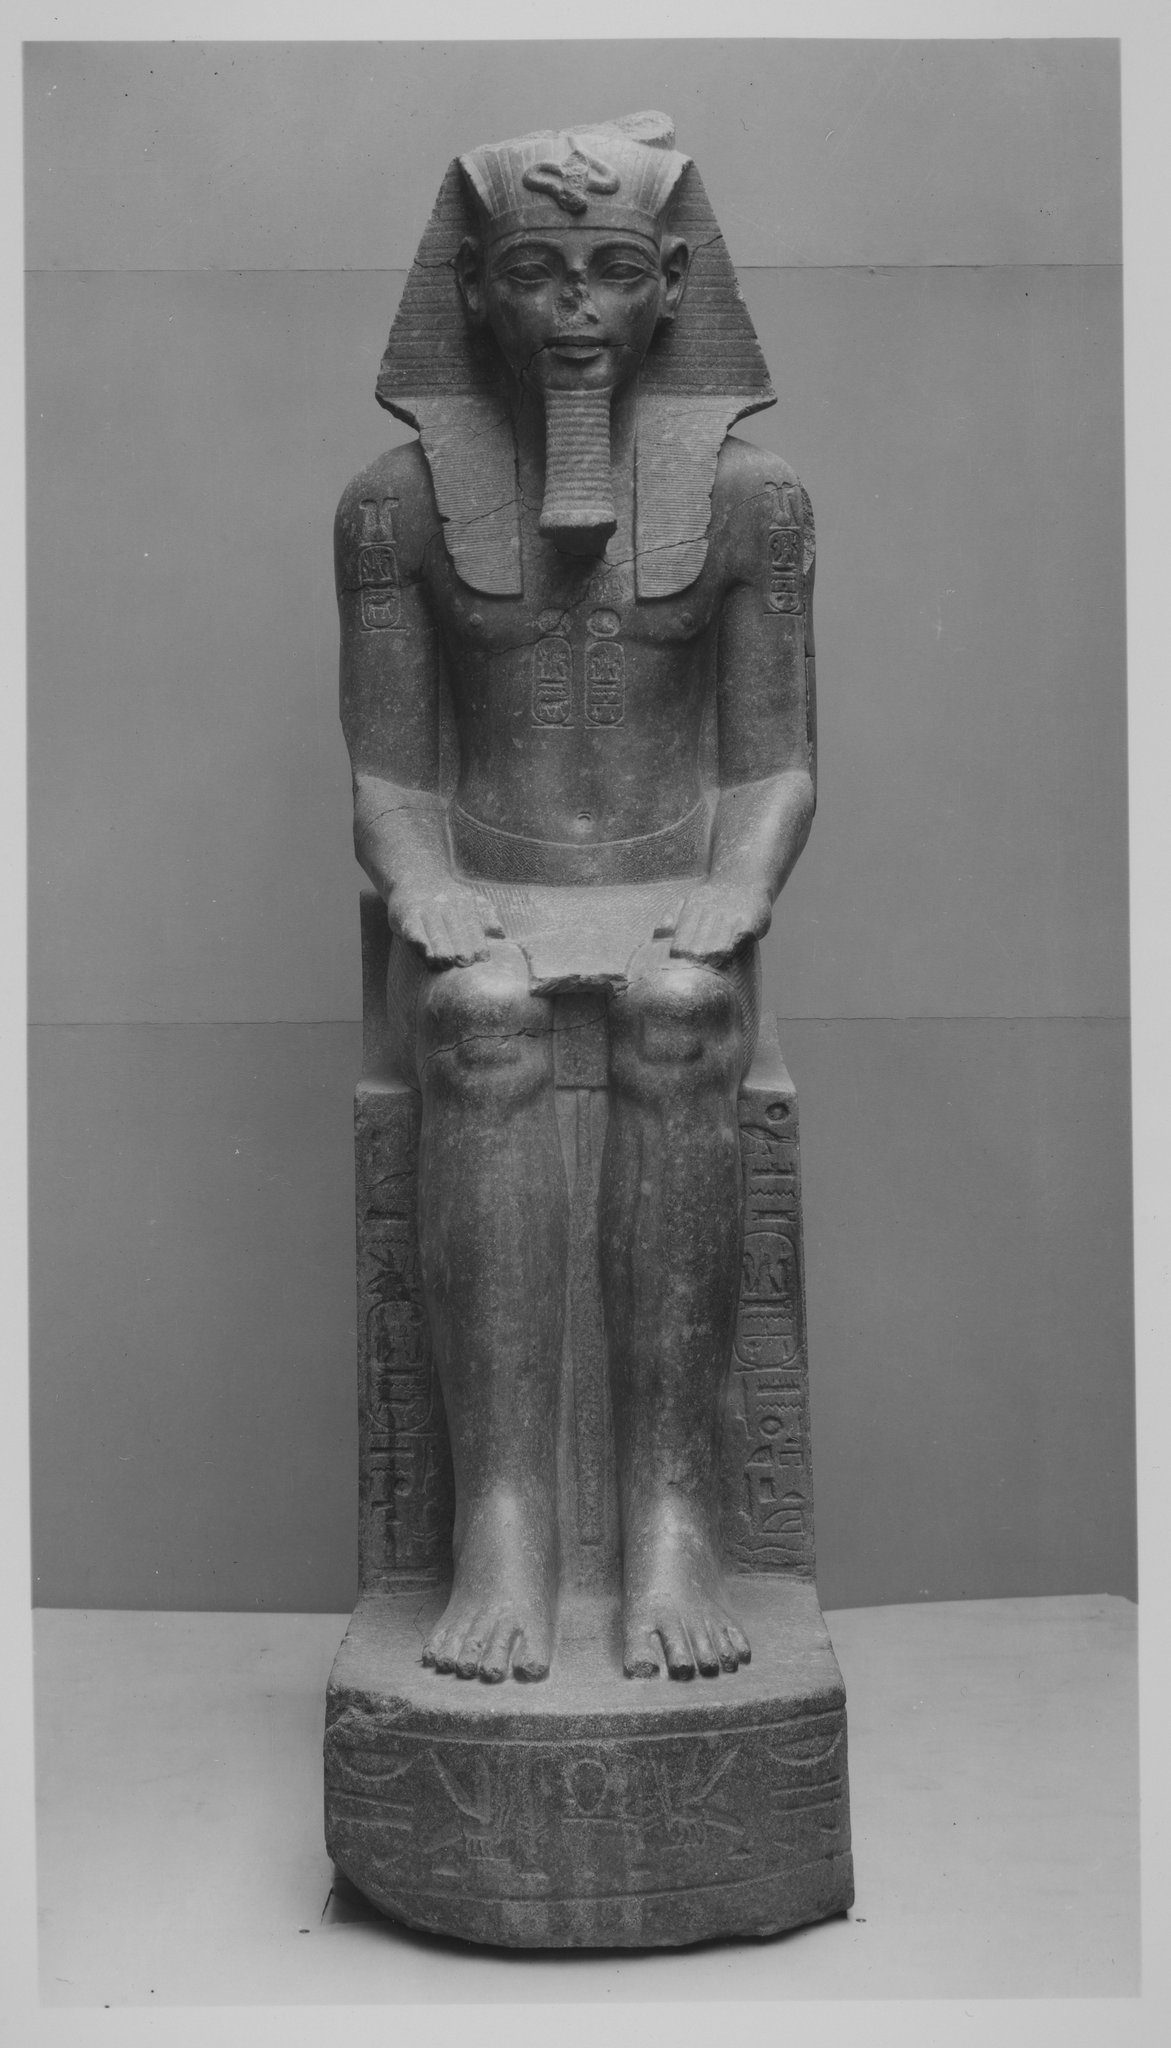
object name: statue, seated king, amenhotep iii, merneptah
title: Colossal Seated Statue of Amenhotep III, reworked, reinscribed by Merneptah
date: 1390-1352 BCE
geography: egypt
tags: men